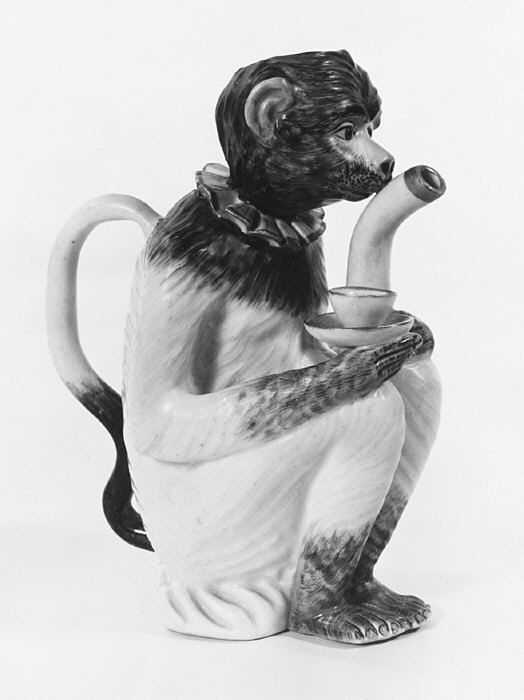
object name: teapot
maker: meissen manufactory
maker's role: manufactory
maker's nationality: german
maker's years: 1710-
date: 1735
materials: hard paste porcelain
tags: monkeys